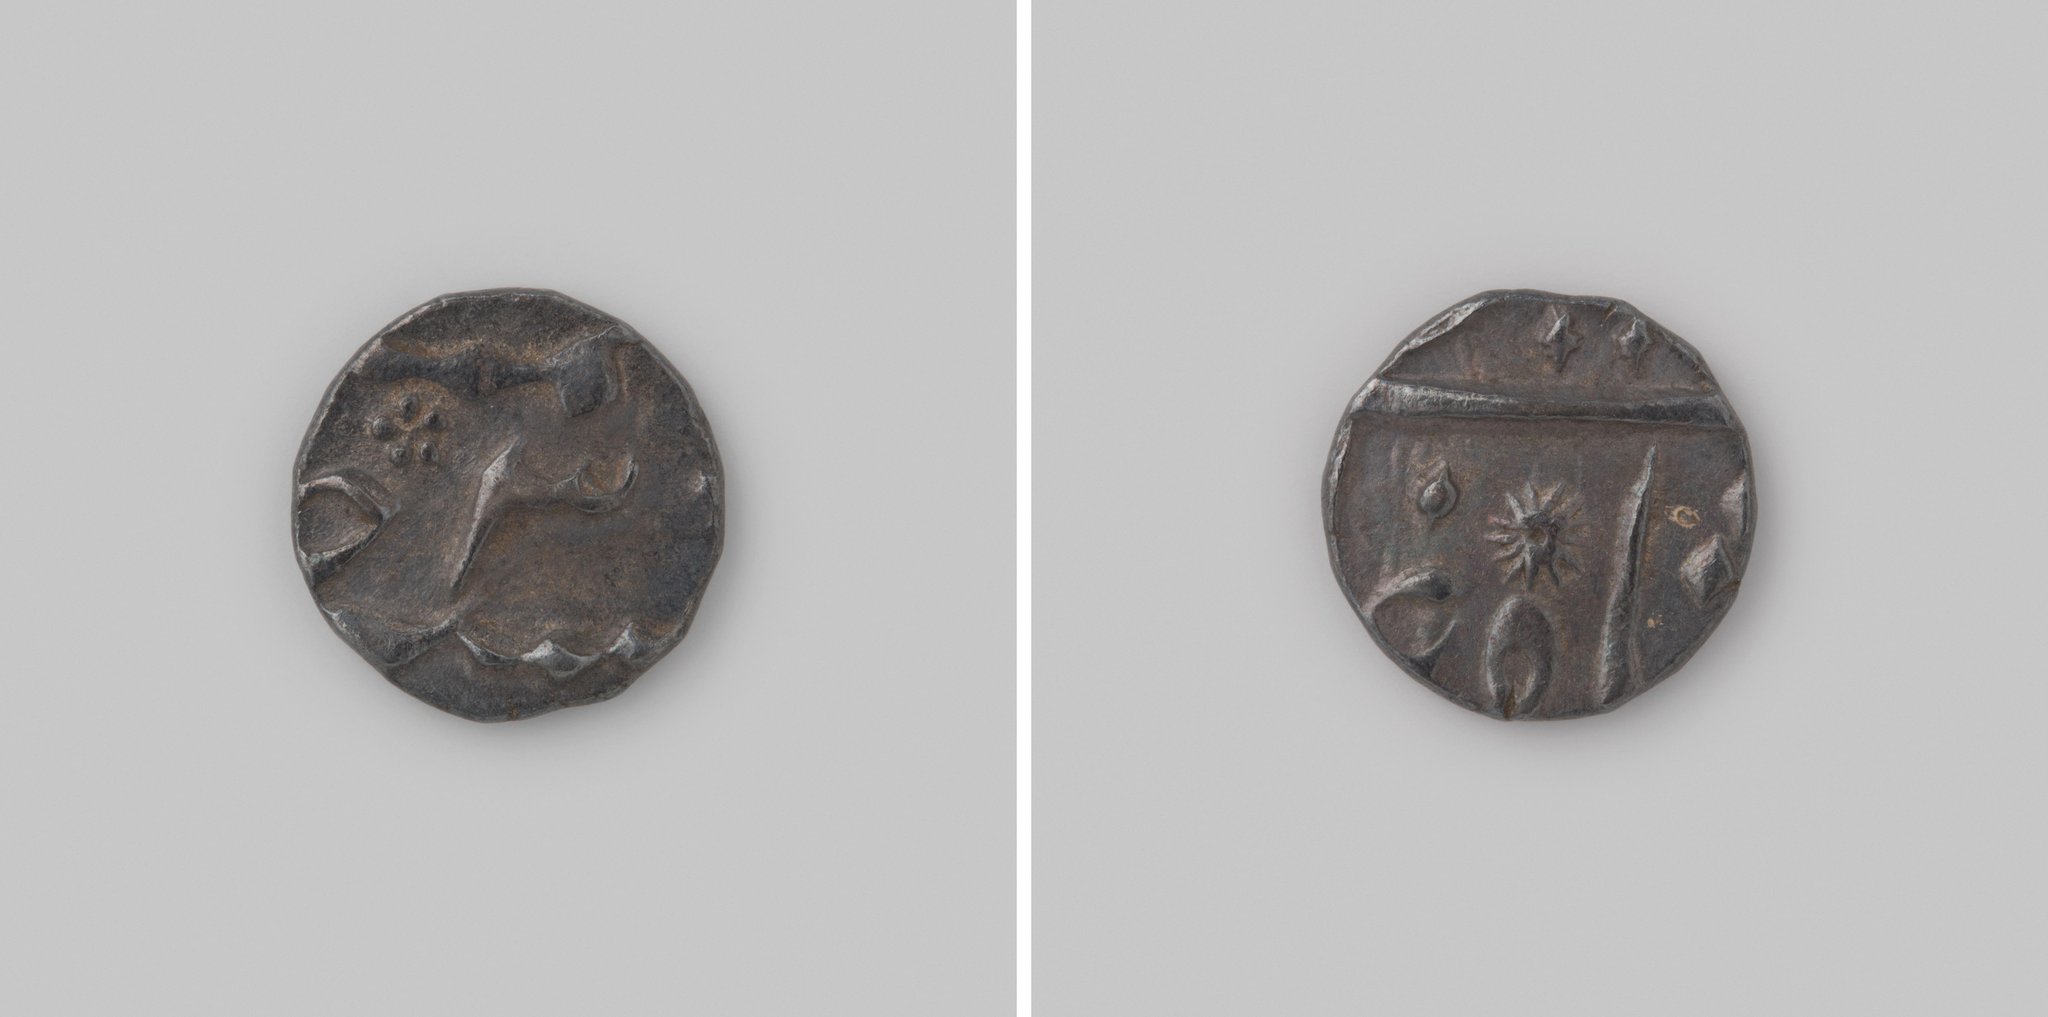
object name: coin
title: 1/8 roepie of anna uit India van sjah Alam II, 1175 [=1761]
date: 1761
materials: silver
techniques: striking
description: Zilveren munt. Voorzijde: in Arabische lettertekens opschrift met versiering. Keerzijde: in Arabische lettertekens in drie regels opschrift met aanduiding regeringsjaar 3 [=1175].